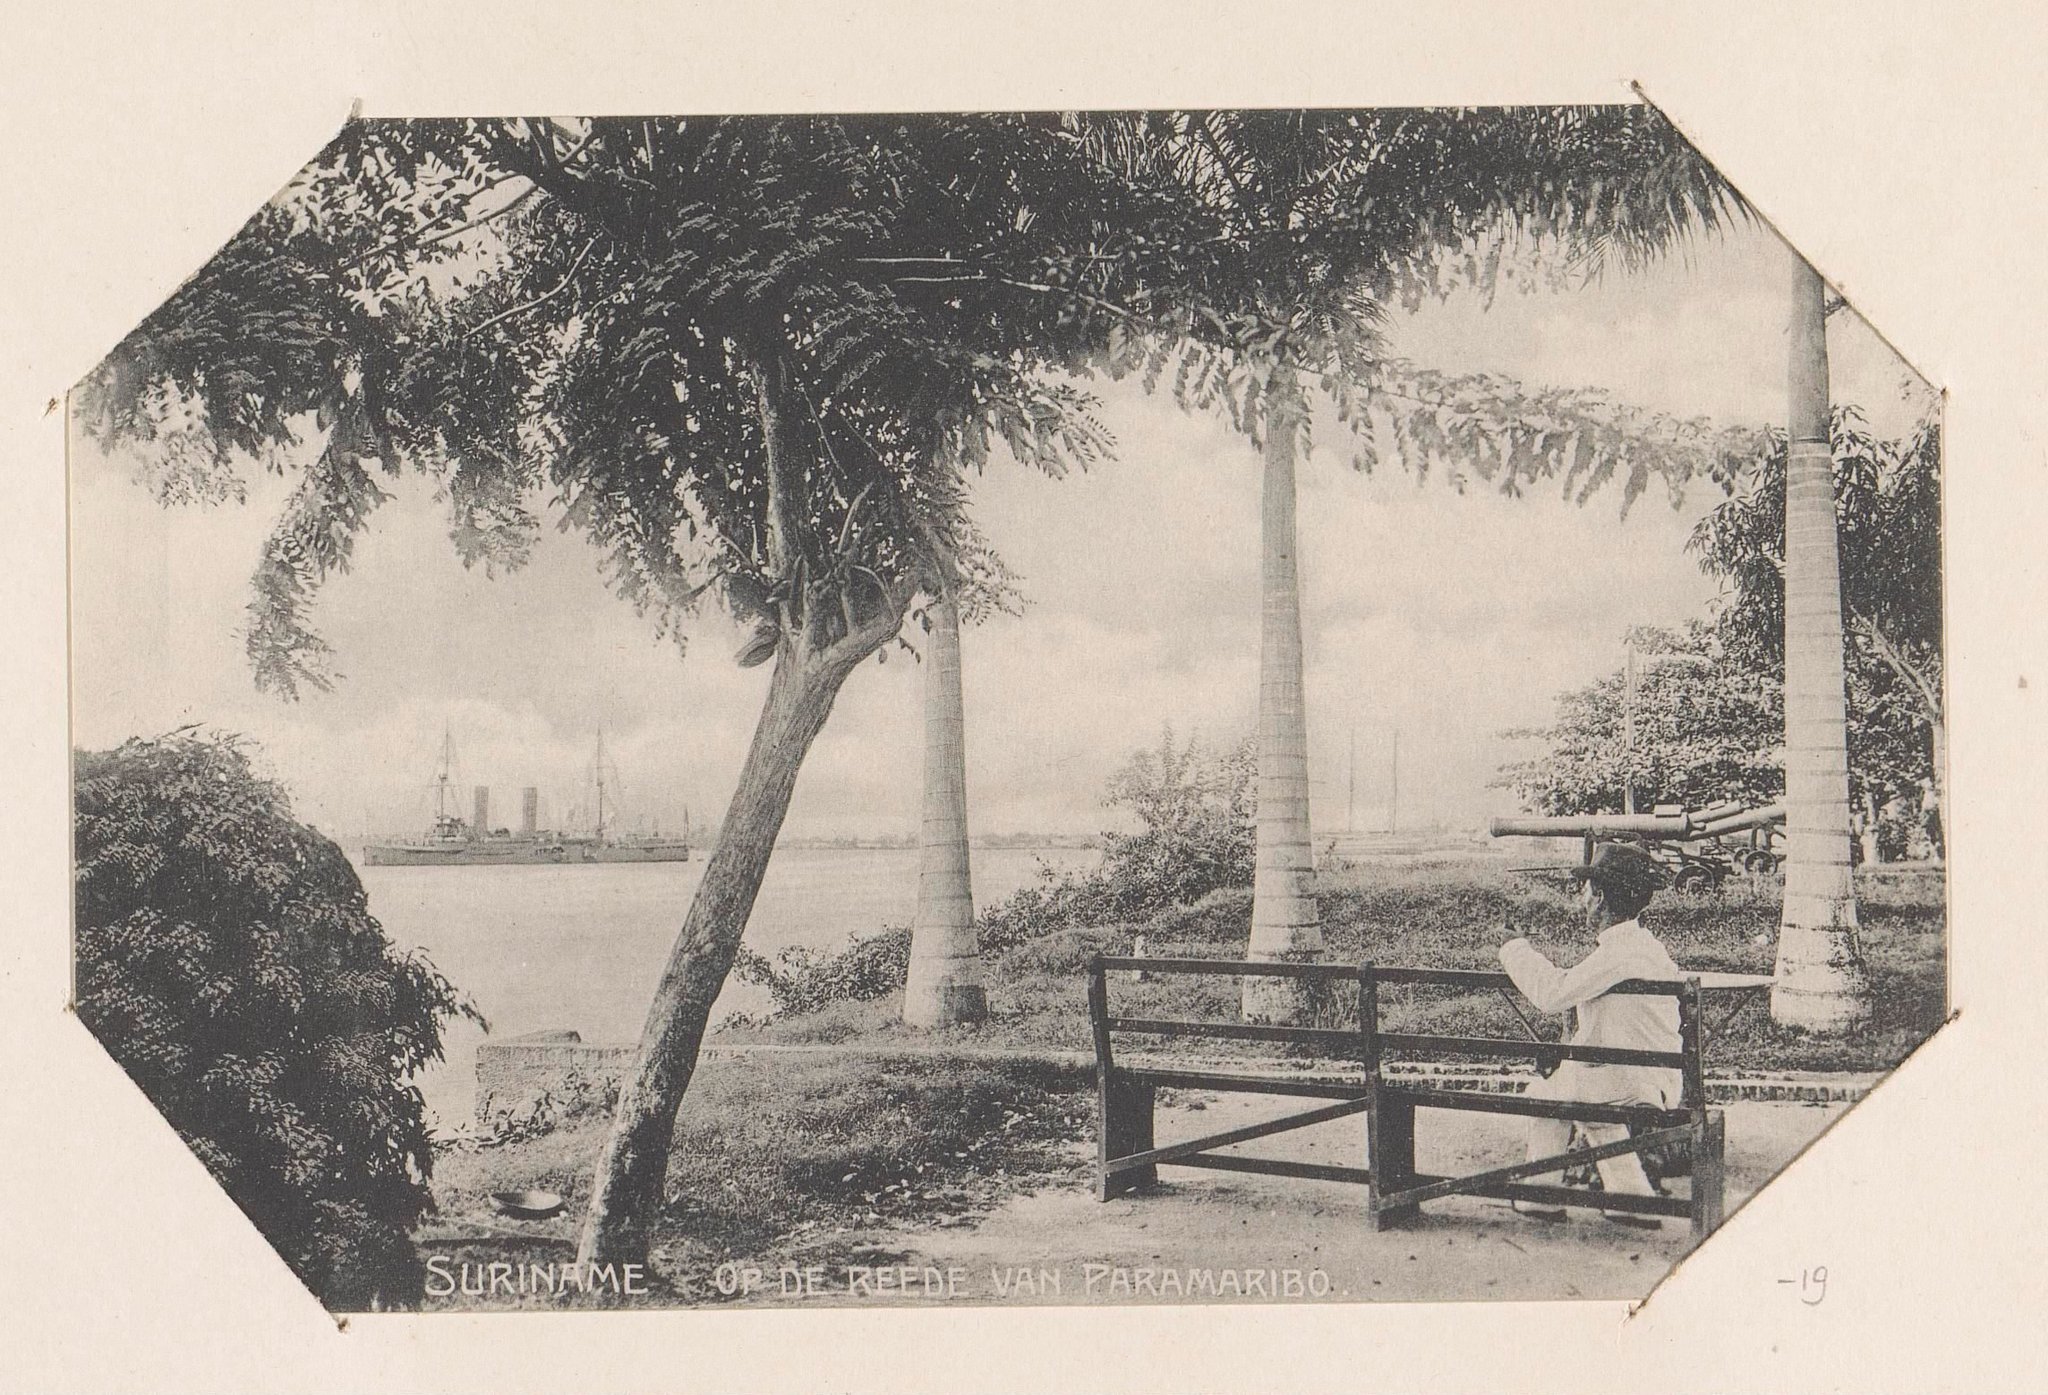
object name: ansichtkaart, prentbriefkaart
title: Suriname. Op de Reede van Paramaribo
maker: eugen klein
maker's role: fotograaf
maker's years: 1869-1927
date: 1900-1910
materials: cardboard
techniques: photograph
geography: paramaribo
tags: public gardens, park (+ city(-scape) with figures, staffage), ship in the roads, roadstead, suriname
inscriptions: serial number: ‘Eigendom van Eugen Klein, Paramaribo No. 197’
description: Gezicht vanuit Paramaribo op schepen die op de rede liggen. Onderdeel van een verzameling van 68 briefkaarten uit Suriname, bijeengebracht in een album als aandenken aan een verblijf in Suriname in september 1911.